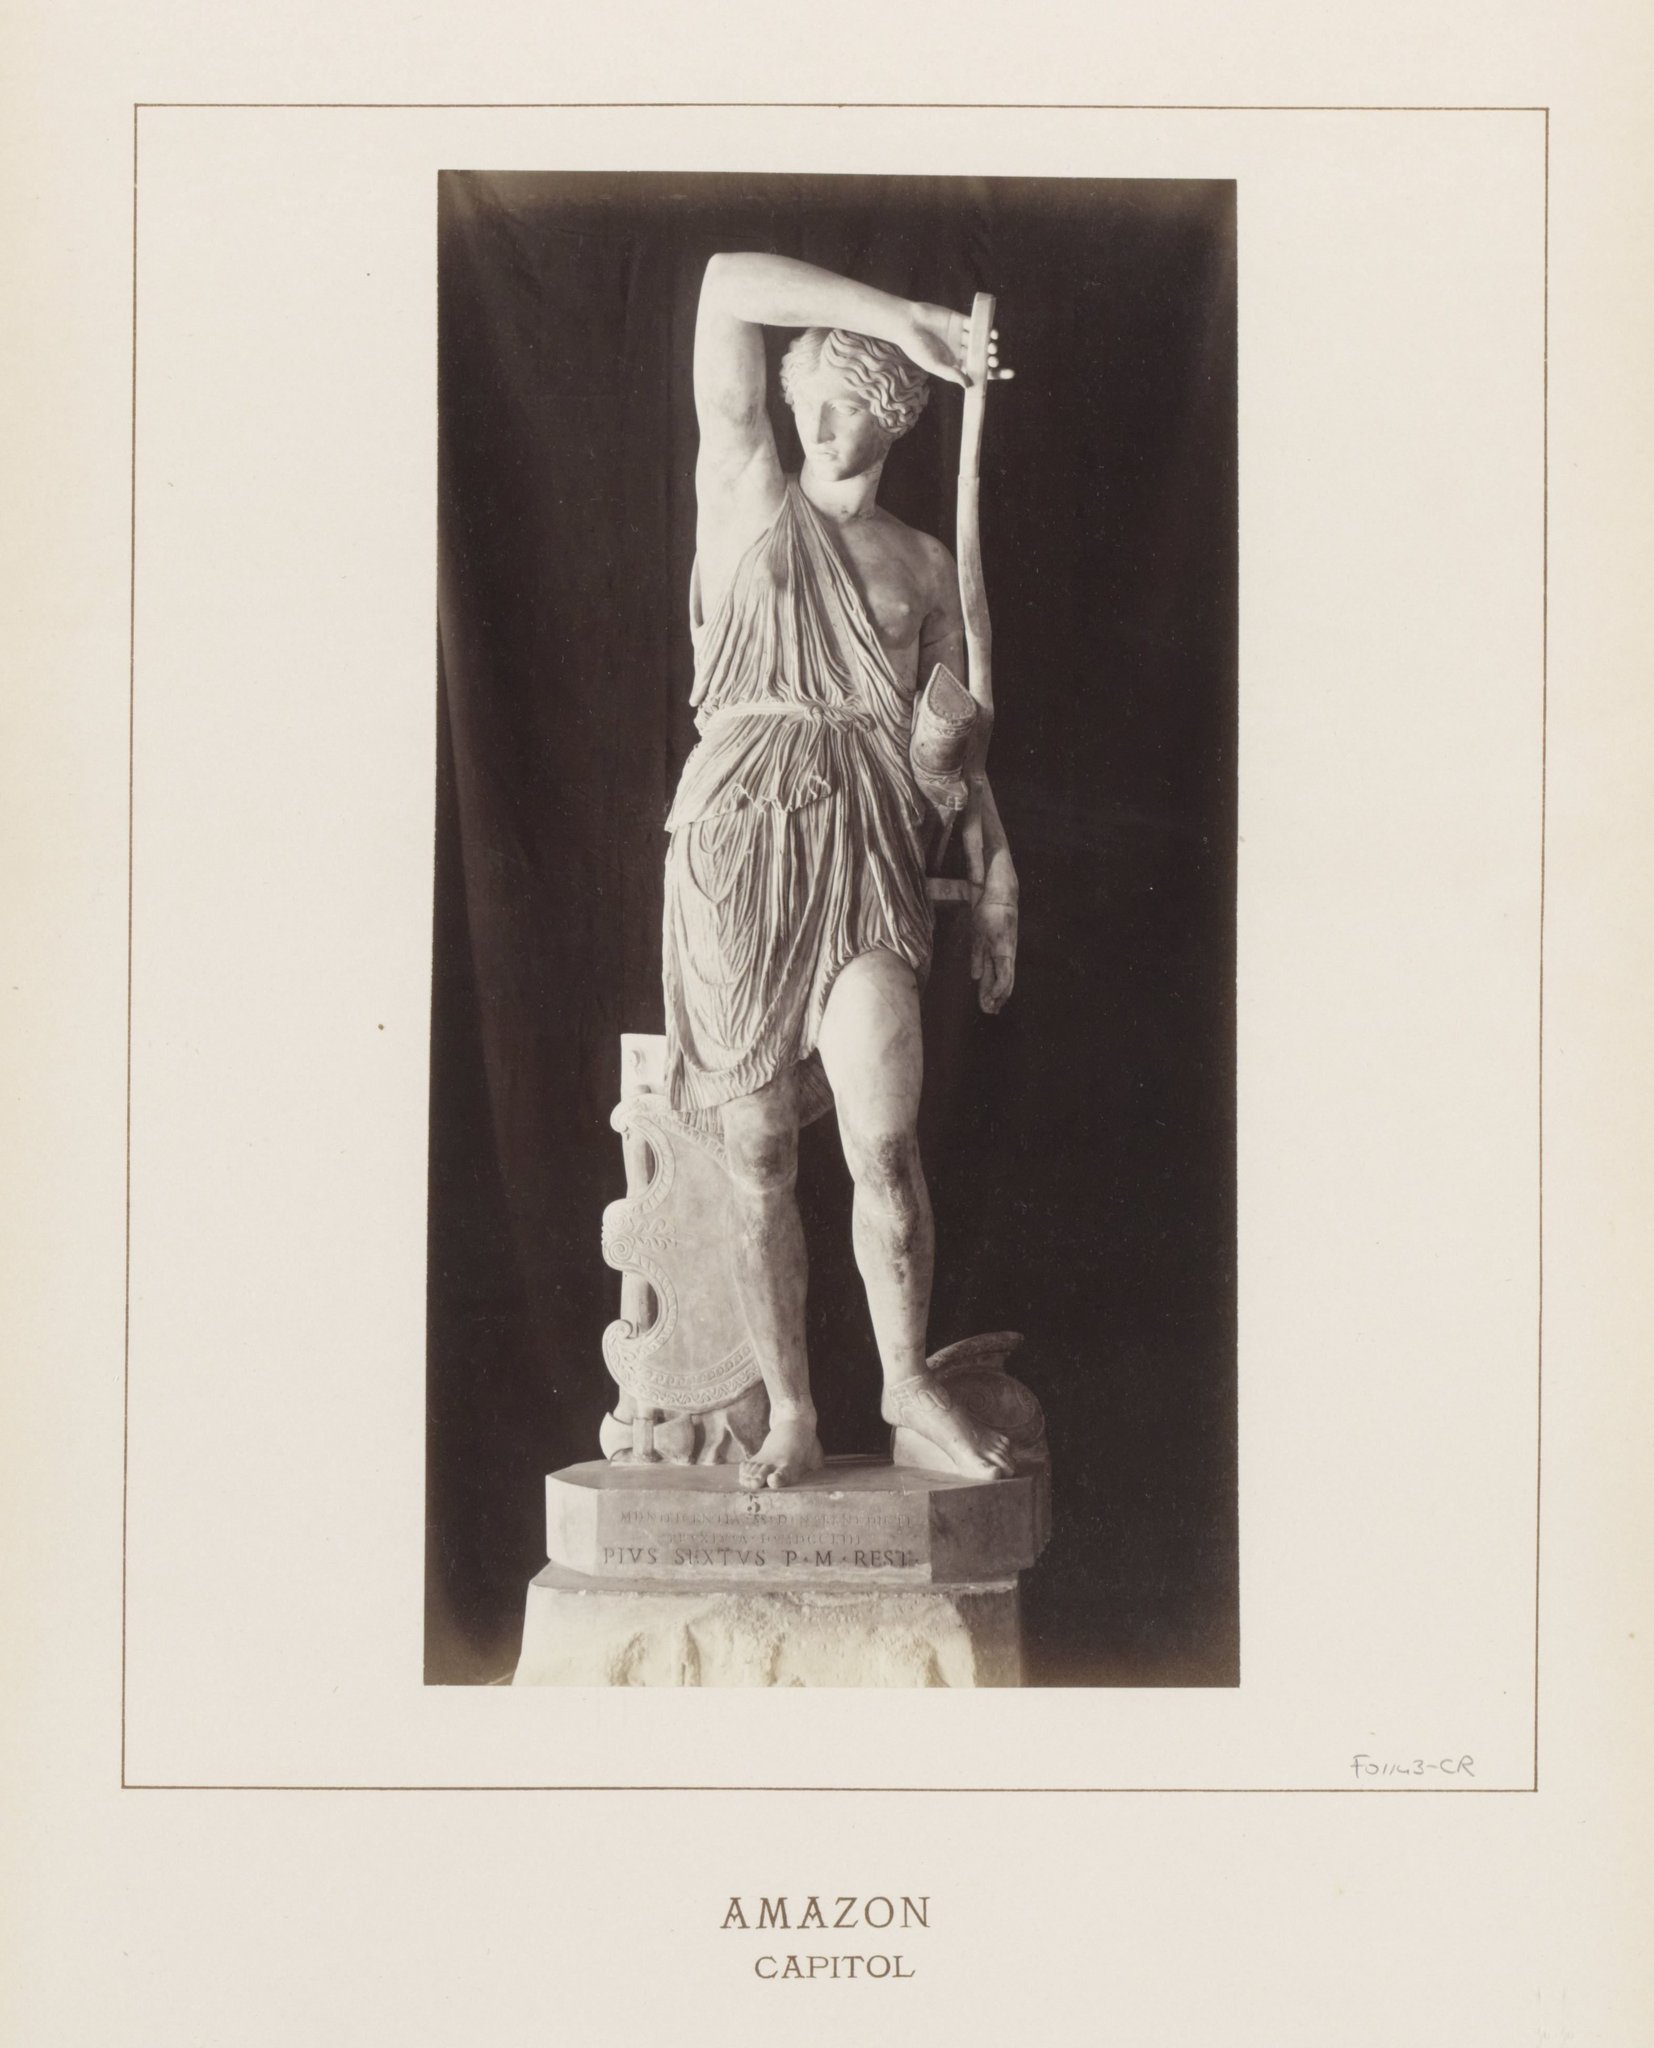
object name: photograph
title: Beeldhouwwerk Gewonde Amazone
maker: Anonymous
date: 1860-1900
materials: photographic support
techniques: albumen print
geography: vatican city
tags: piece of sculpture, reproduction of a piece of sculpture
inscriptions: number: ‘5’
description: Onderdeel van Fotoalbum met opnames van bezienswaardigheden en kunstwerken in Rome.